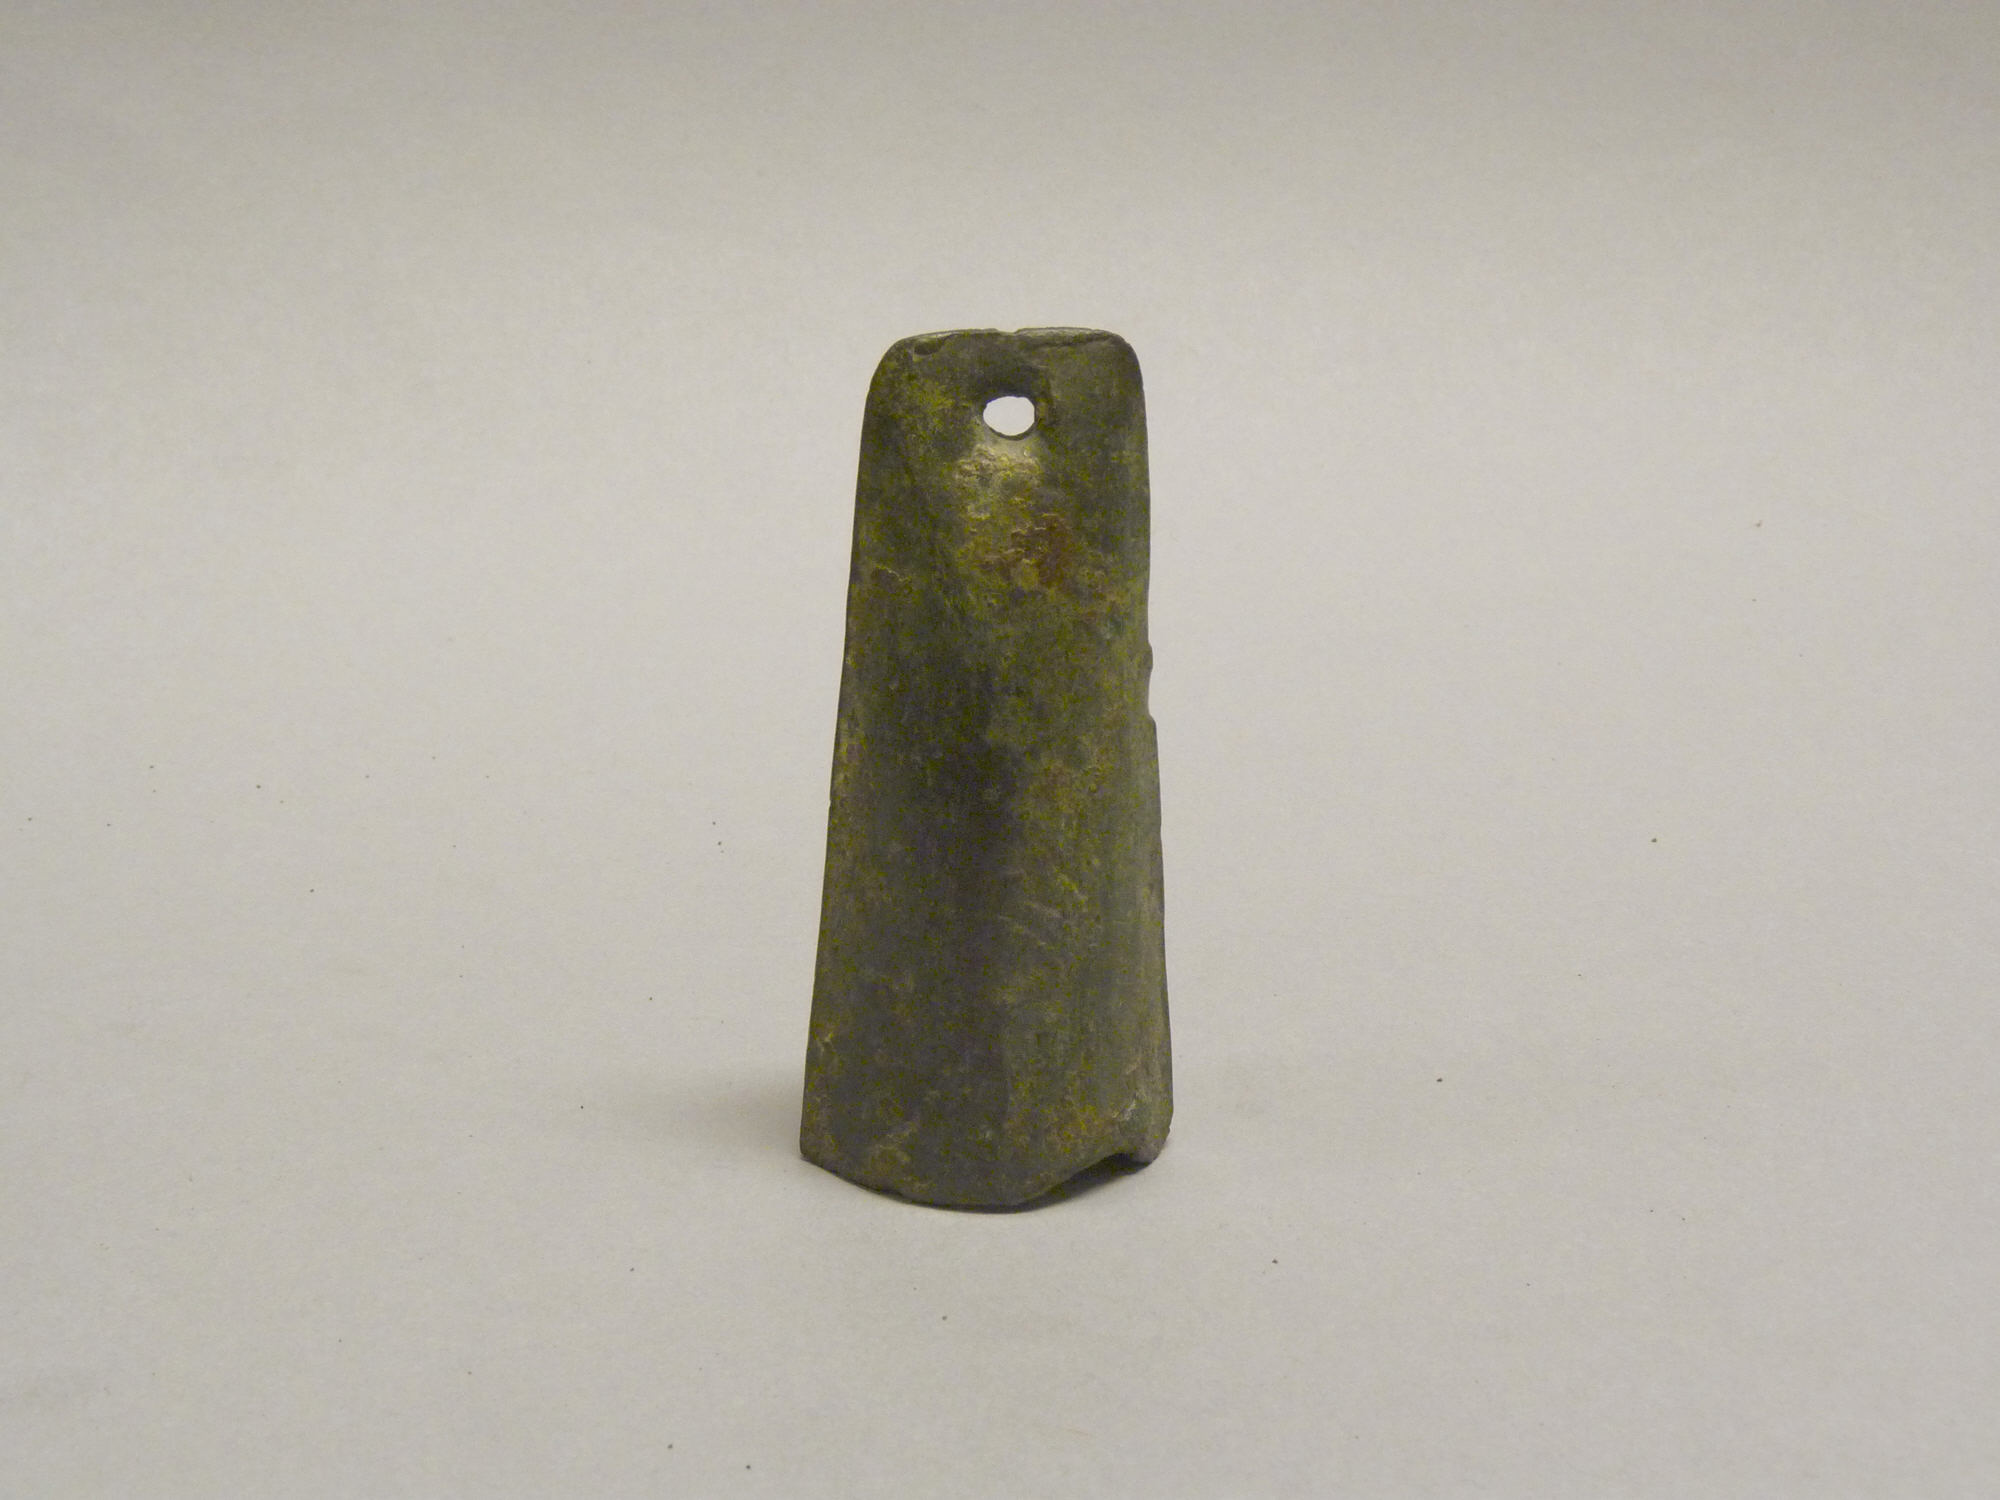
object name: bell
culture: vietnamese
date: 500 BCE-300 CE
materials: bronze